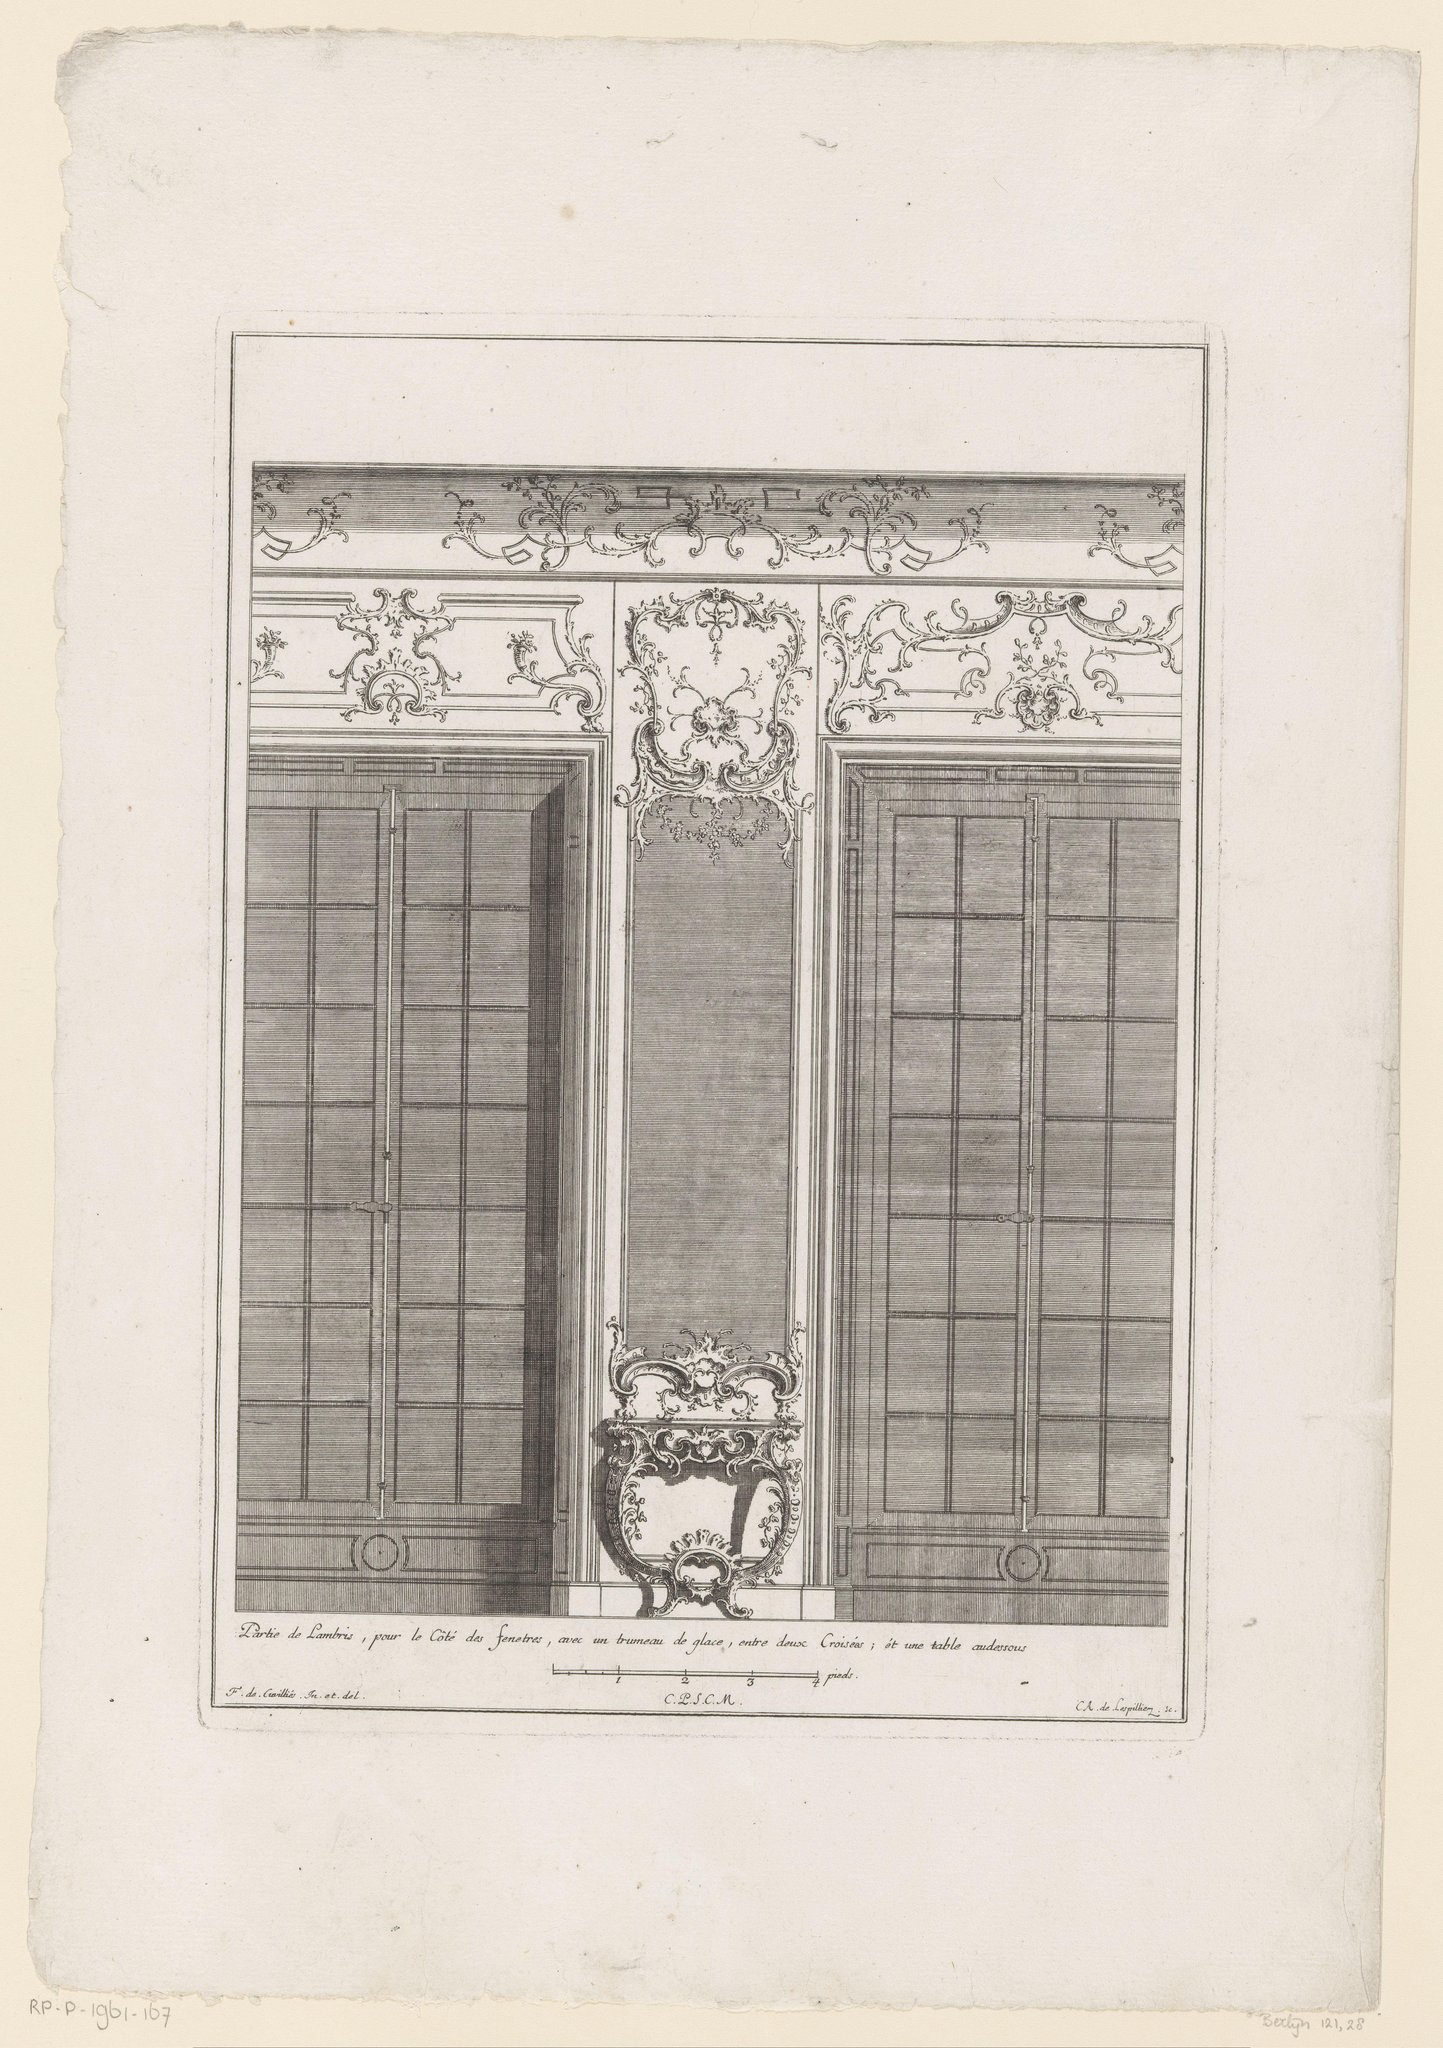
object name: ornament print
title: Partie de Lambris, pour le Côté des fenetres, avec un trumeau de glace, entre deux Croisées; et un table audessous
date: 1733-1768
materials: paper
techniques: etching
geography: germany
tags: window, table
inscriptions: collector's mark: Lugt 2228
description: Twee ramen met in het midden een paneel met spiegel en een geornamenteerde tafel.